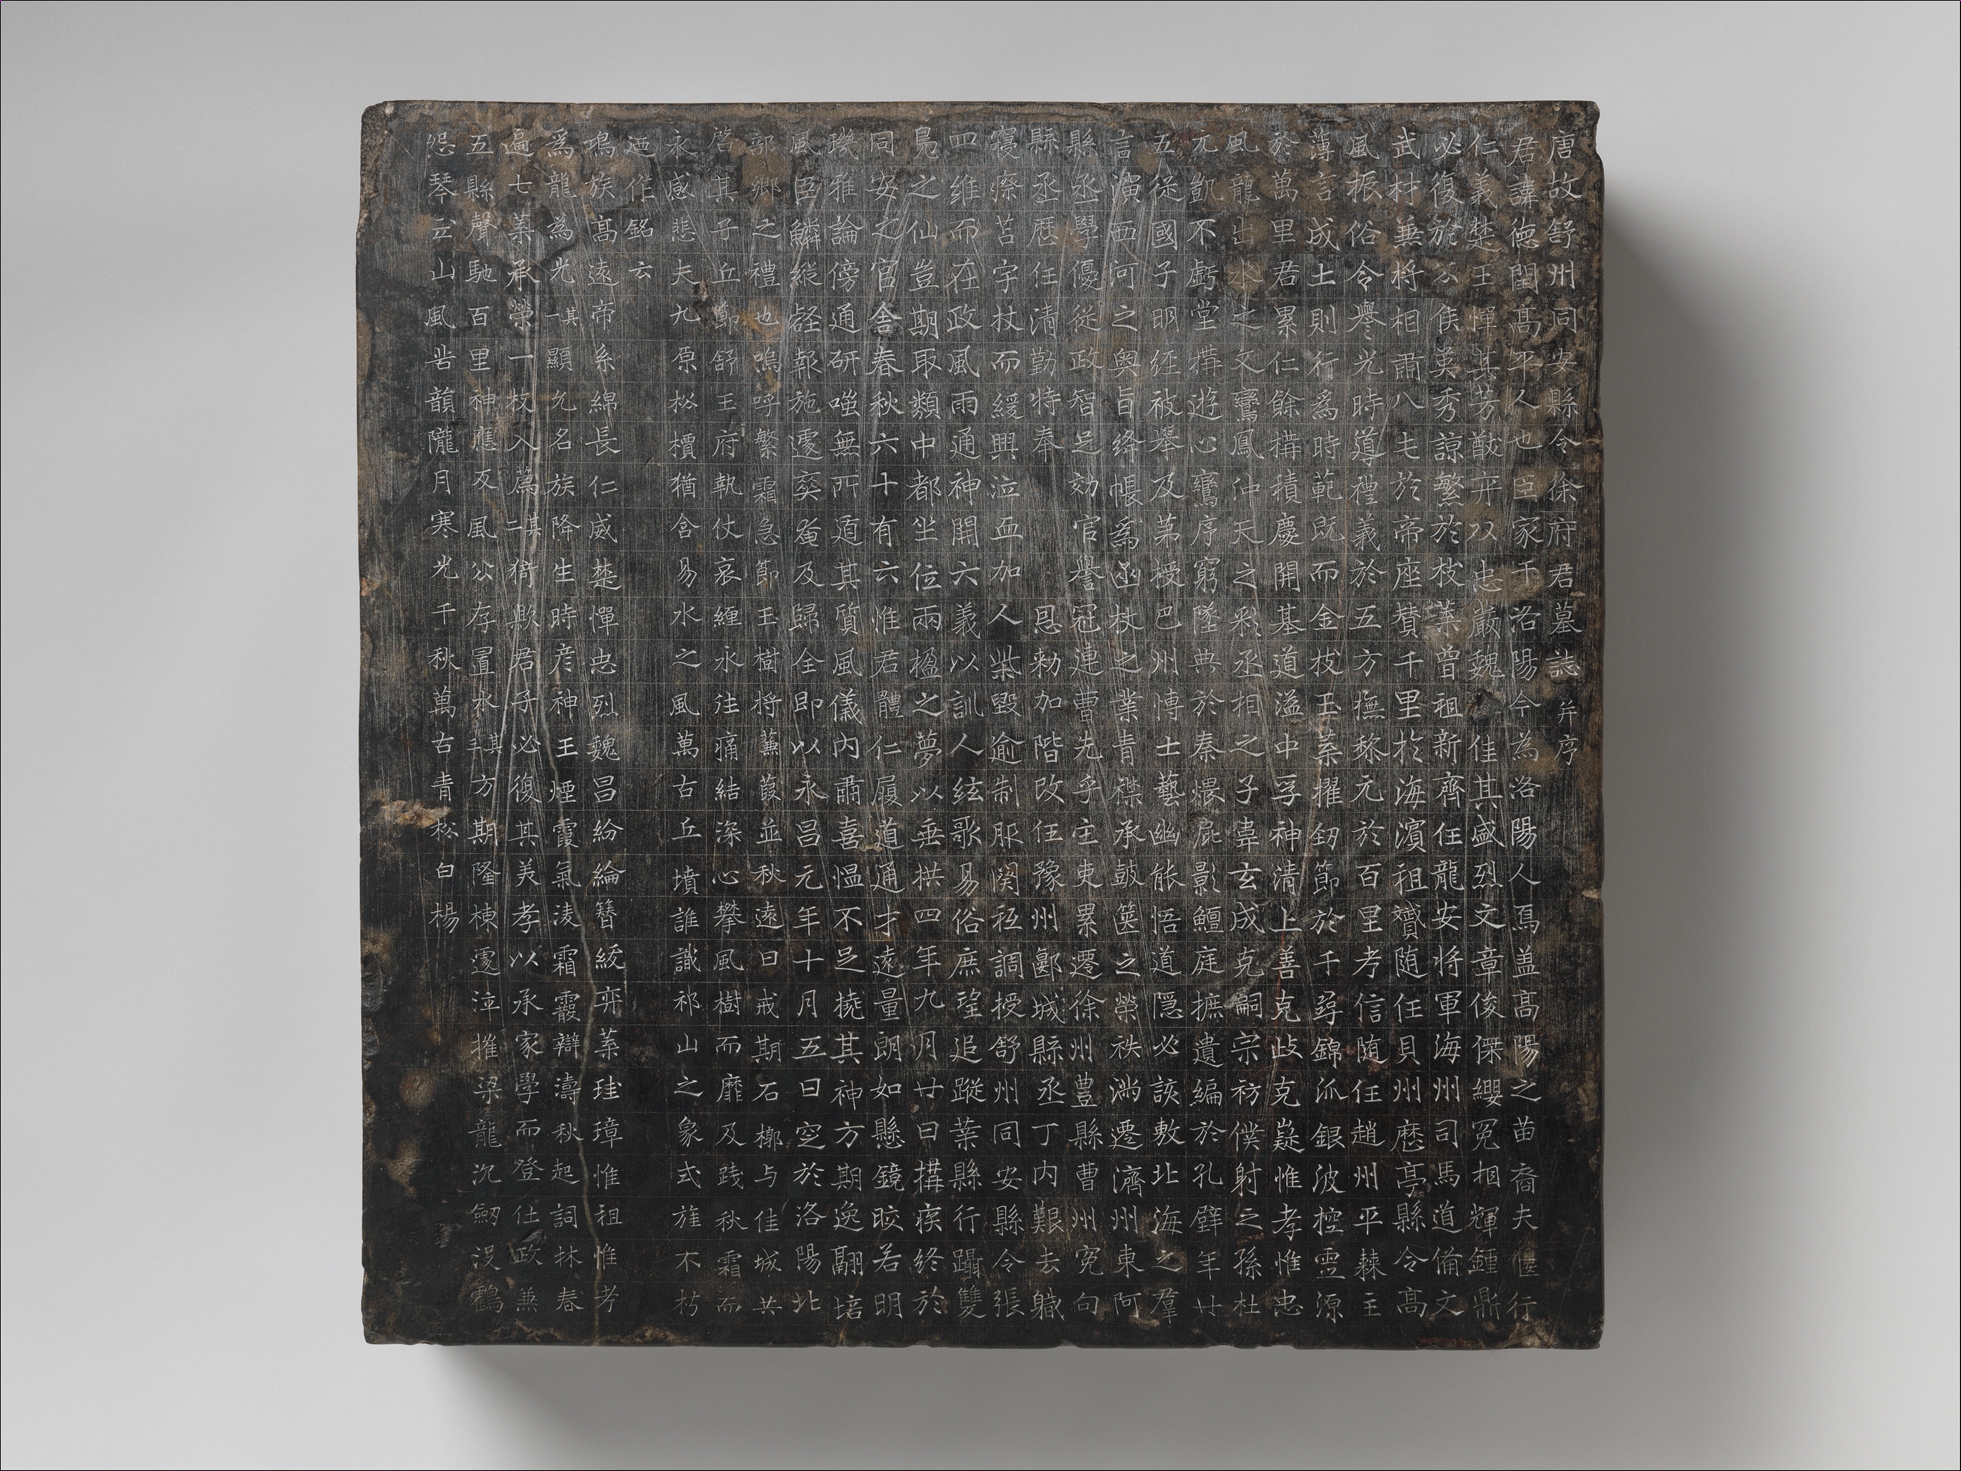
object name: epitaph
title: Epitaph with Cover for Master Xu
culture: chinese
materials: limestone